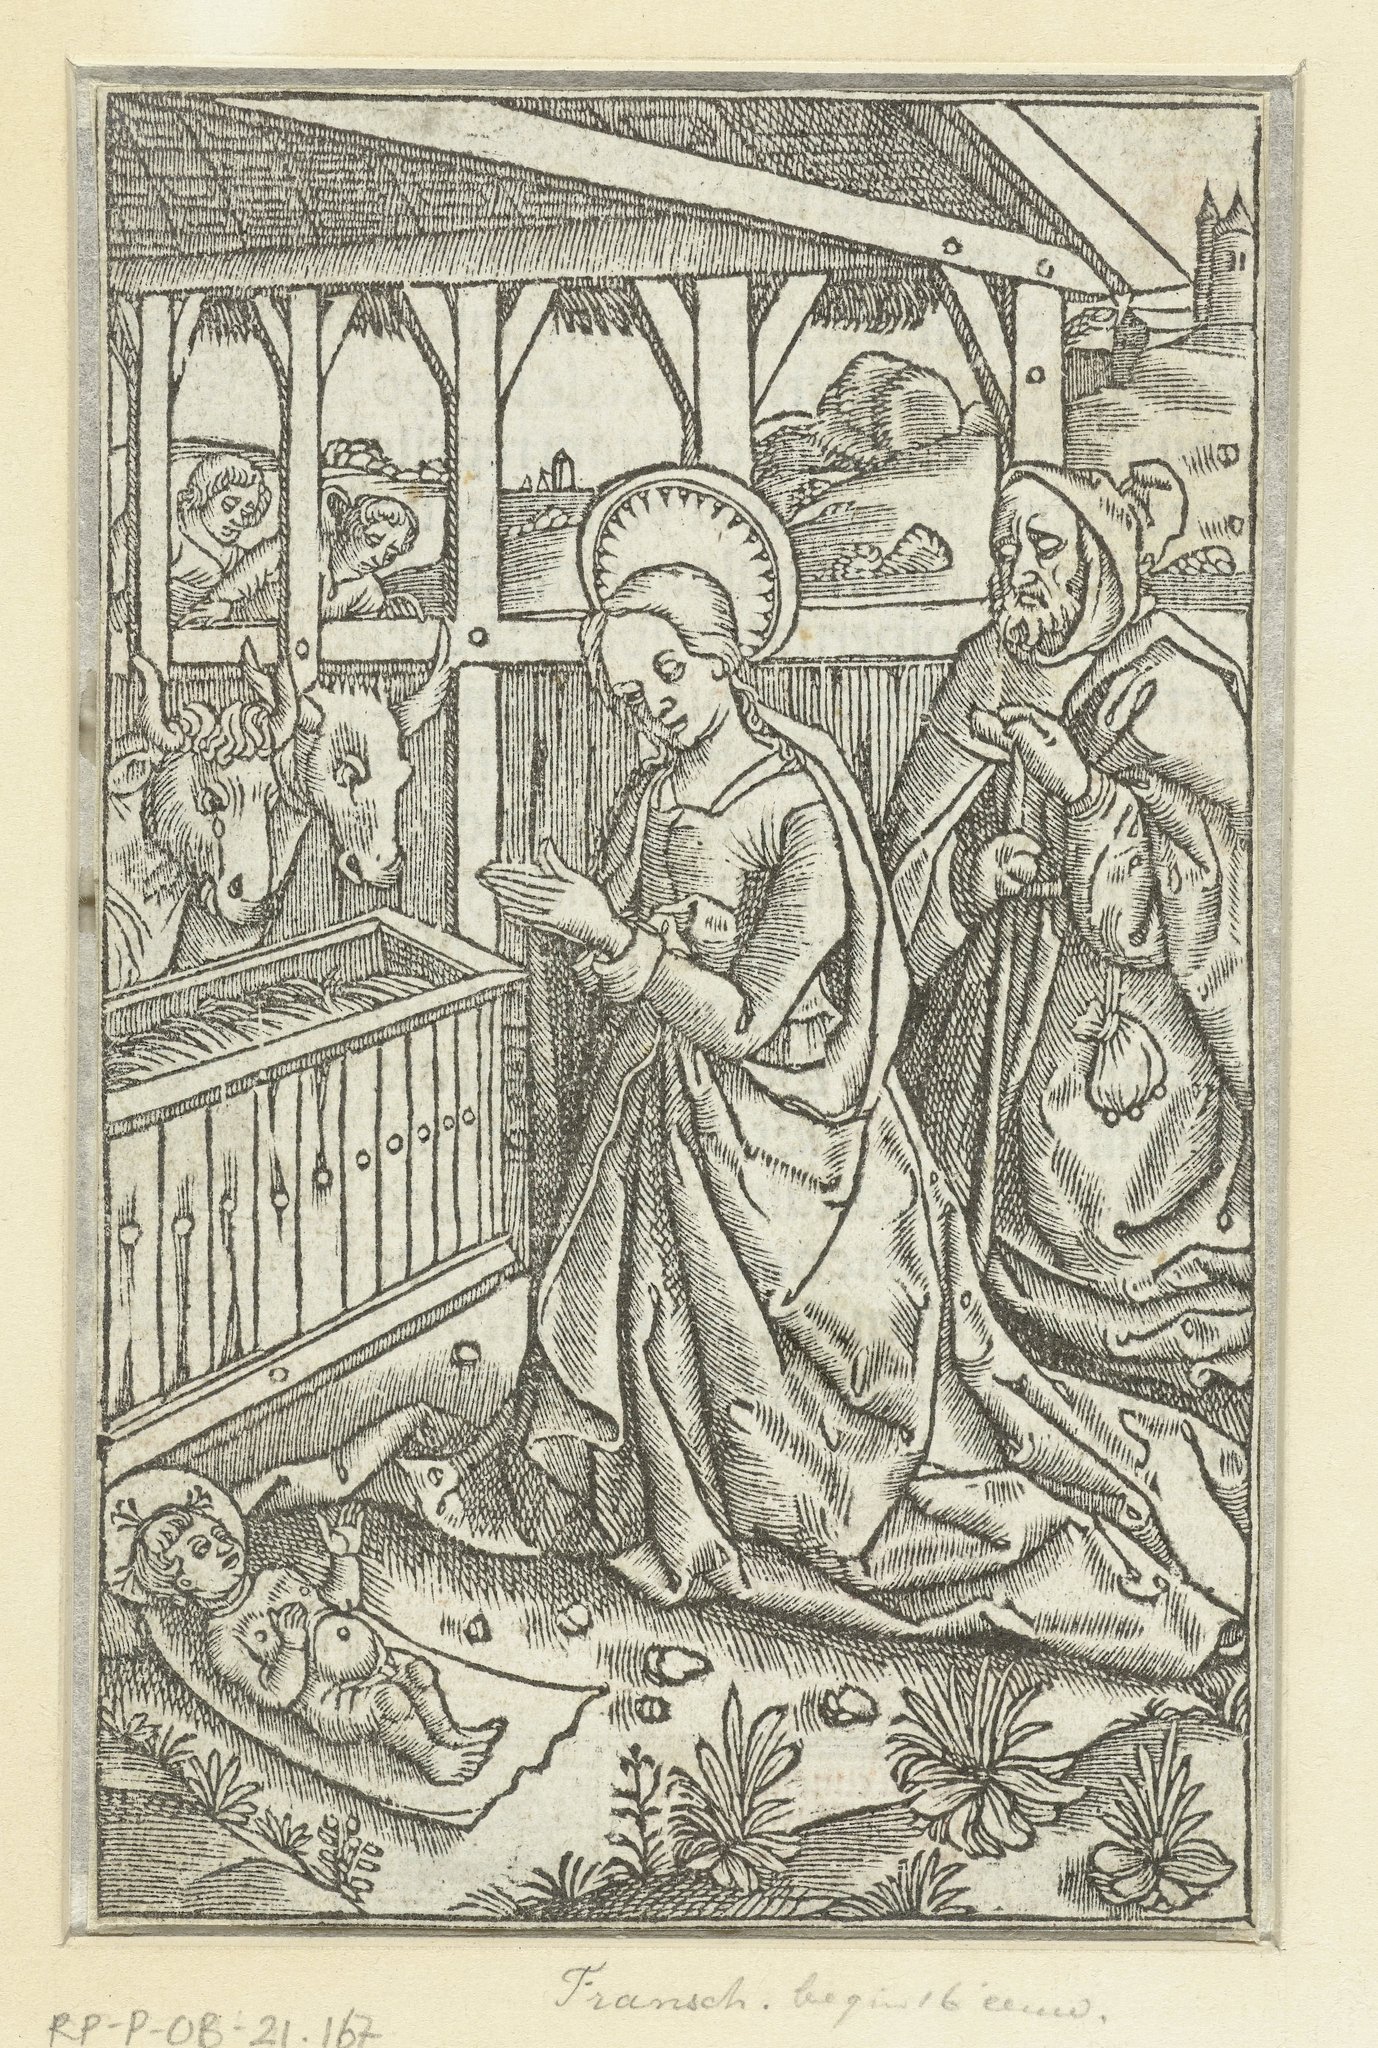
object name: print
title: De geboorte van Christus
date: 1507-1508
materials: paper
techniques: woodcut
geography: paris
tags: mary, joseph and the new-born christ (nativity)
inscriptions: collector's mark: Lugt 240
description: Illustraties uit "Horae B. Mariae Virginis", uitgegeven door Thielman Kerver, Parijs 1508. Op verso tekst in het Latijn, gedrukt in zwart en rood. Langs de rand kleine voorstellingen (houtsneden). Botke, K.